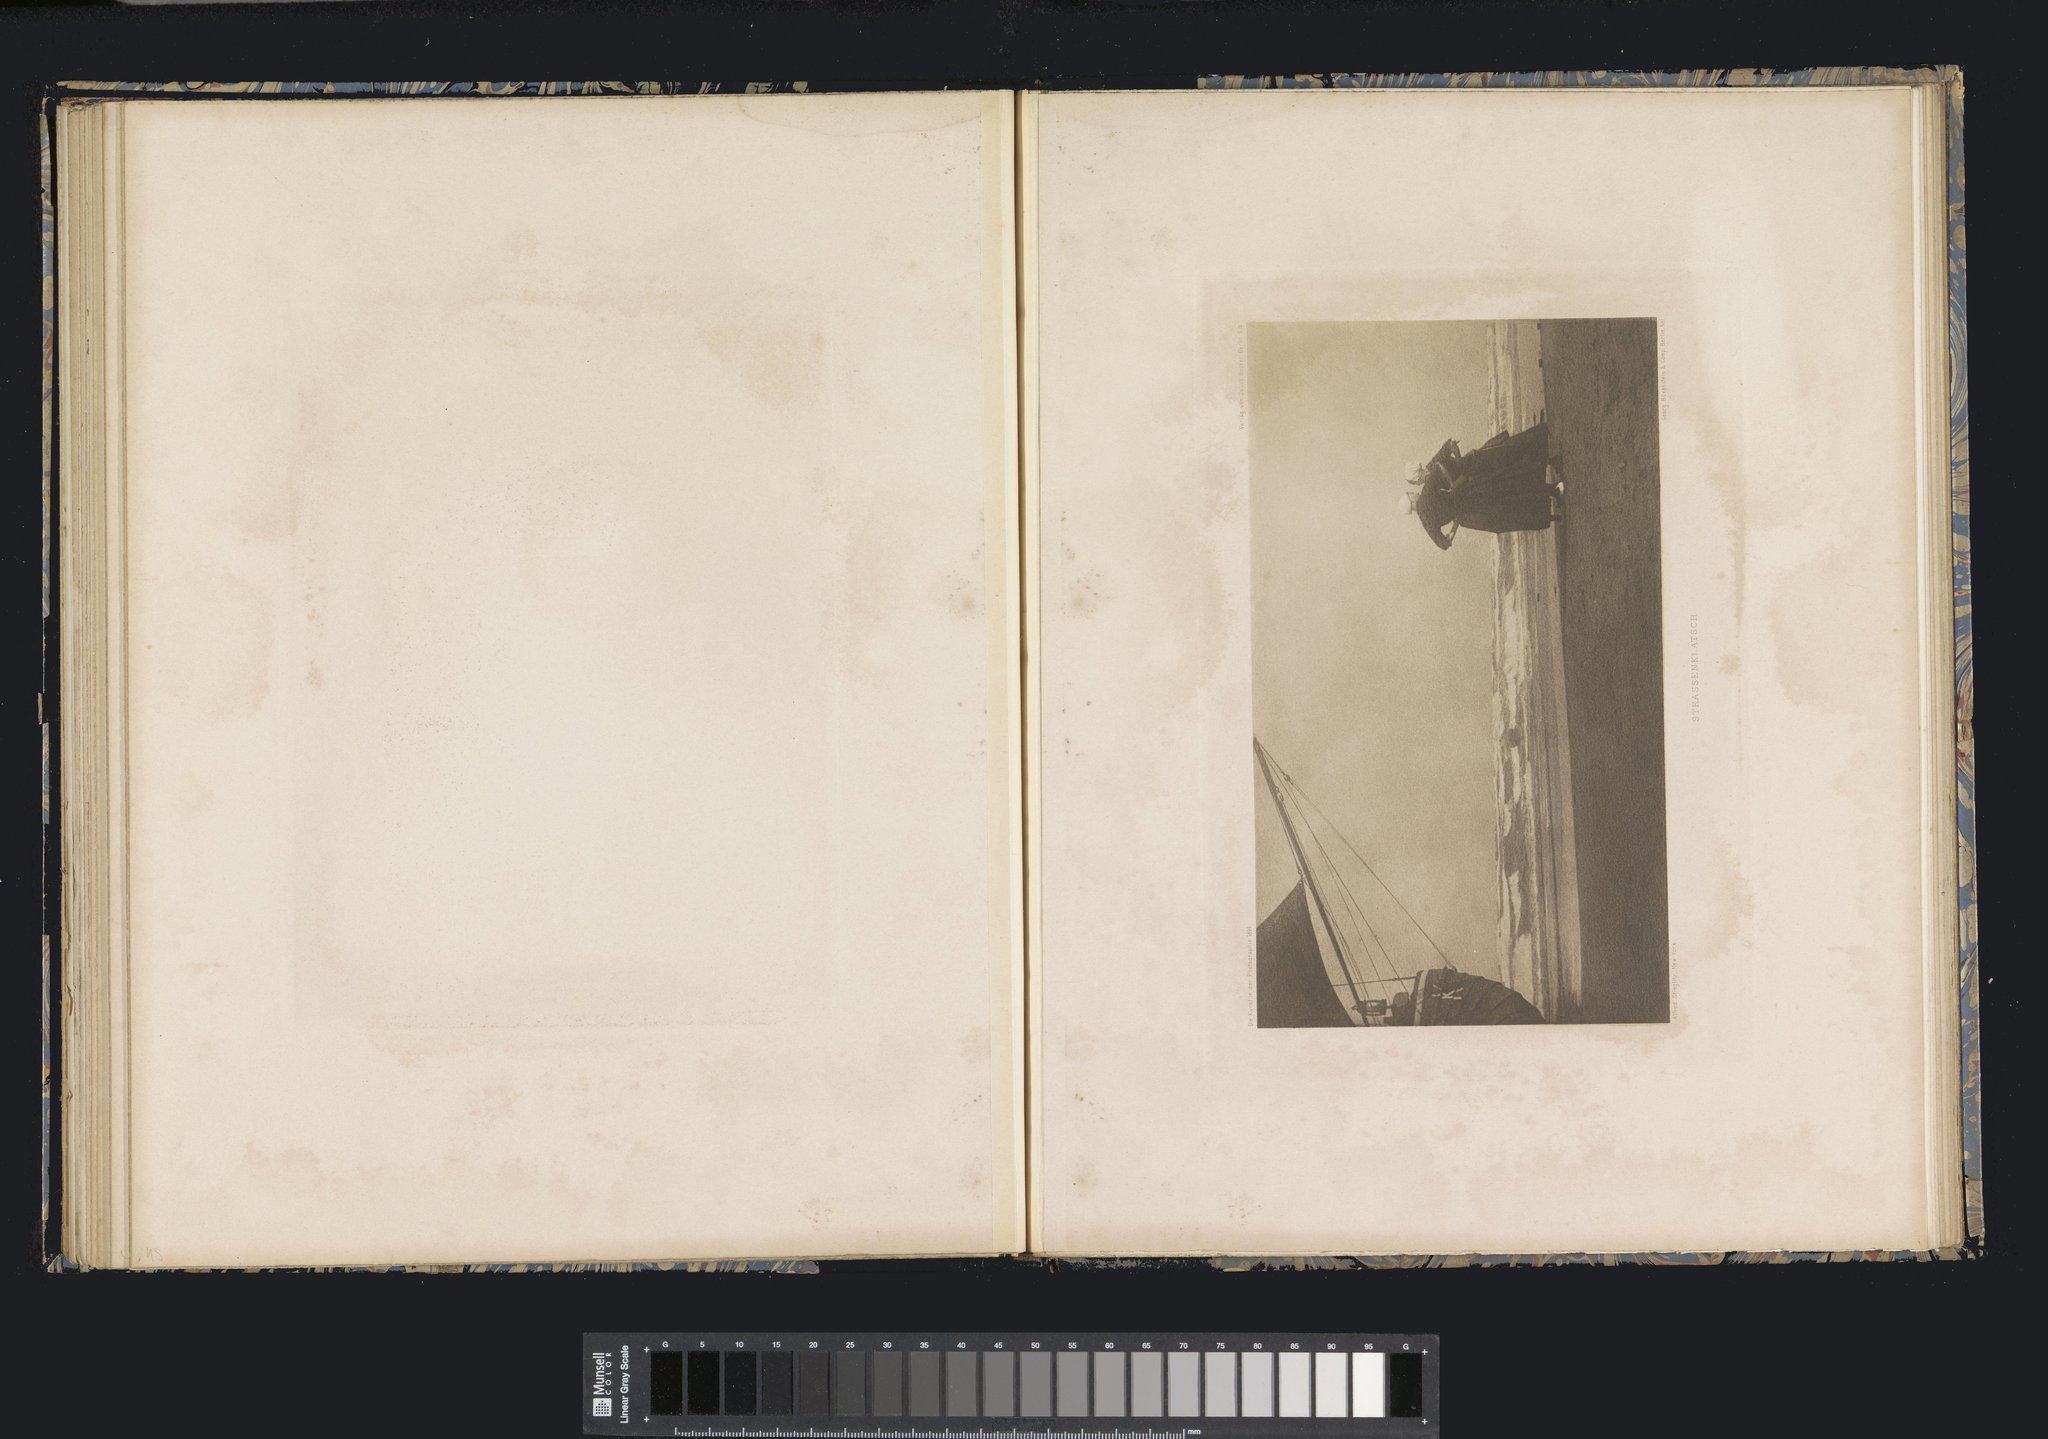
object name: page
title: Strassenklatsch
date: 1889-1899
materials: paper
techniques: photoaquatint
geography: germany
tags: adult woman, ships (in general), beach